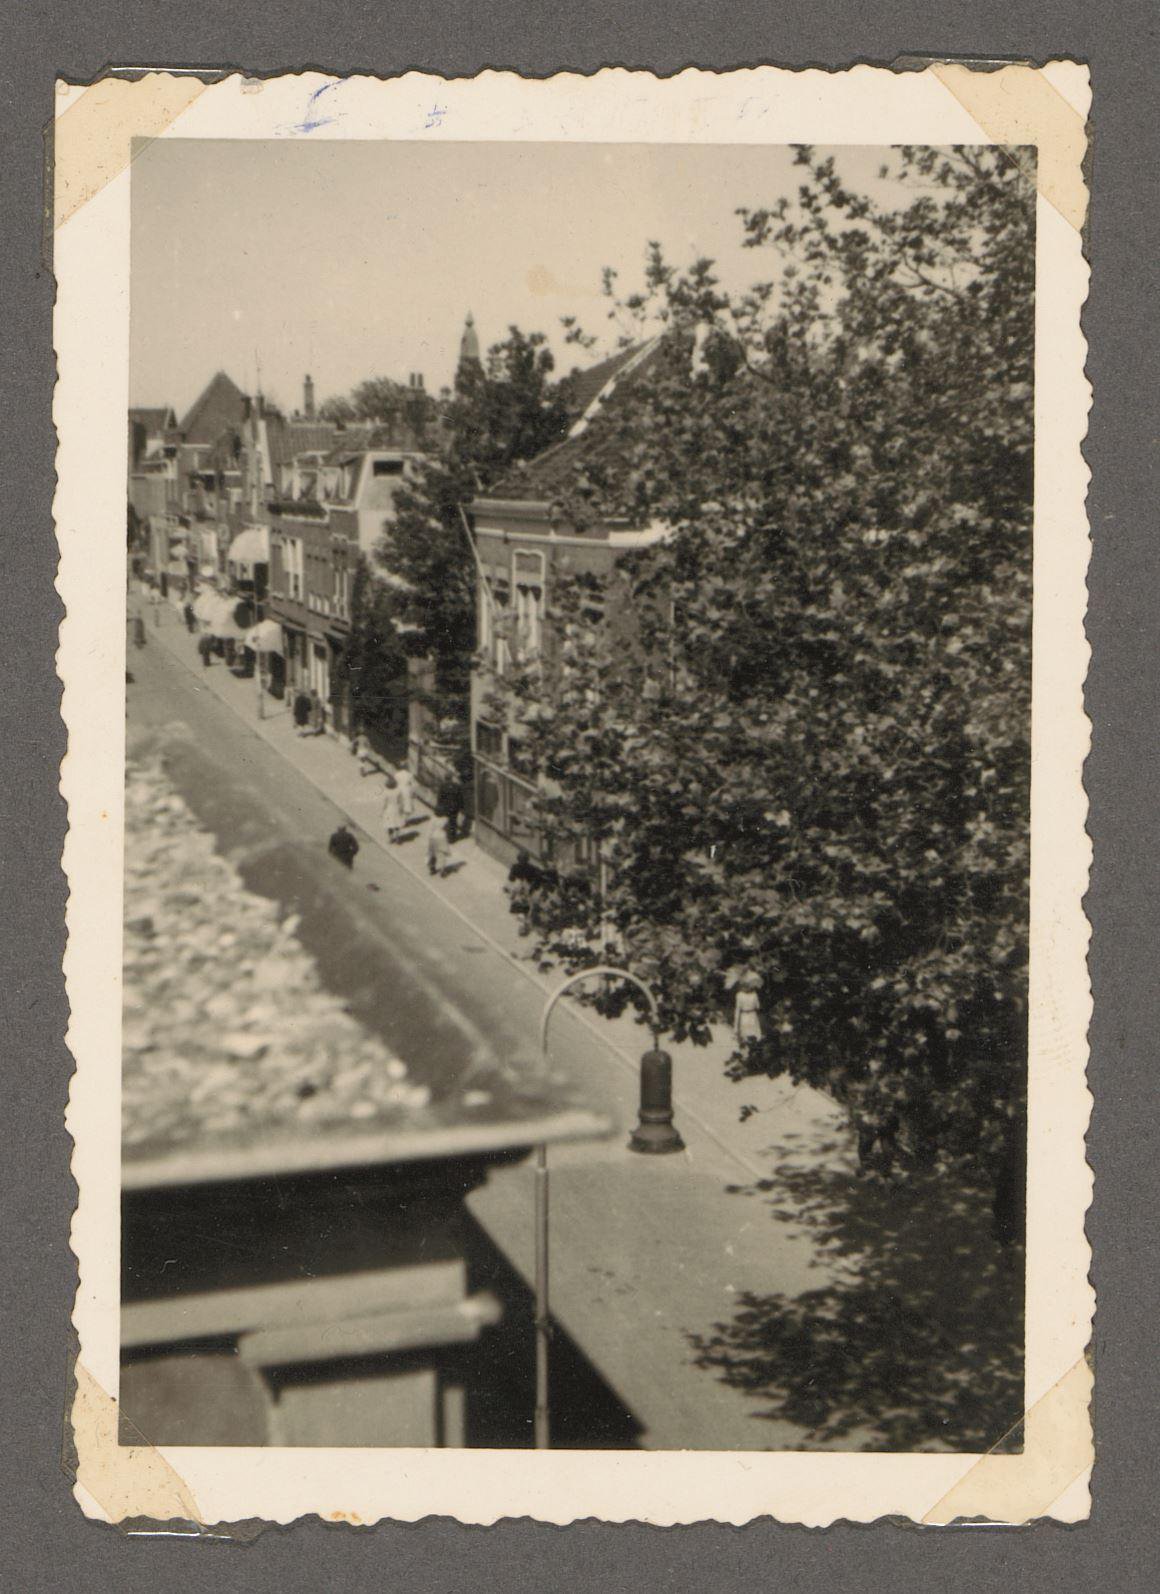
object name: photograph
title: Schiedamseweg te Vlaardingen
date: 1941-1945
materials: paper, photographic support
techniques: gelatin silver print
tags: street, rotterdam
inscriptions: annotation: ‘Vlaardingen/Rotterdam’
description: Gezicht op de Schiedamseweg te Vlaardingen in westelijke richting met rechts bomen van de tuin van het gebouw van de NV de Harmonie. Opname vanaf het dak van het pand Schiedamseweg 14, gedurende enkele oorlogsjaren in gebruik als Dienststelle van het 9e Räumbootsflottille van de Duitse Kriegsmarine.